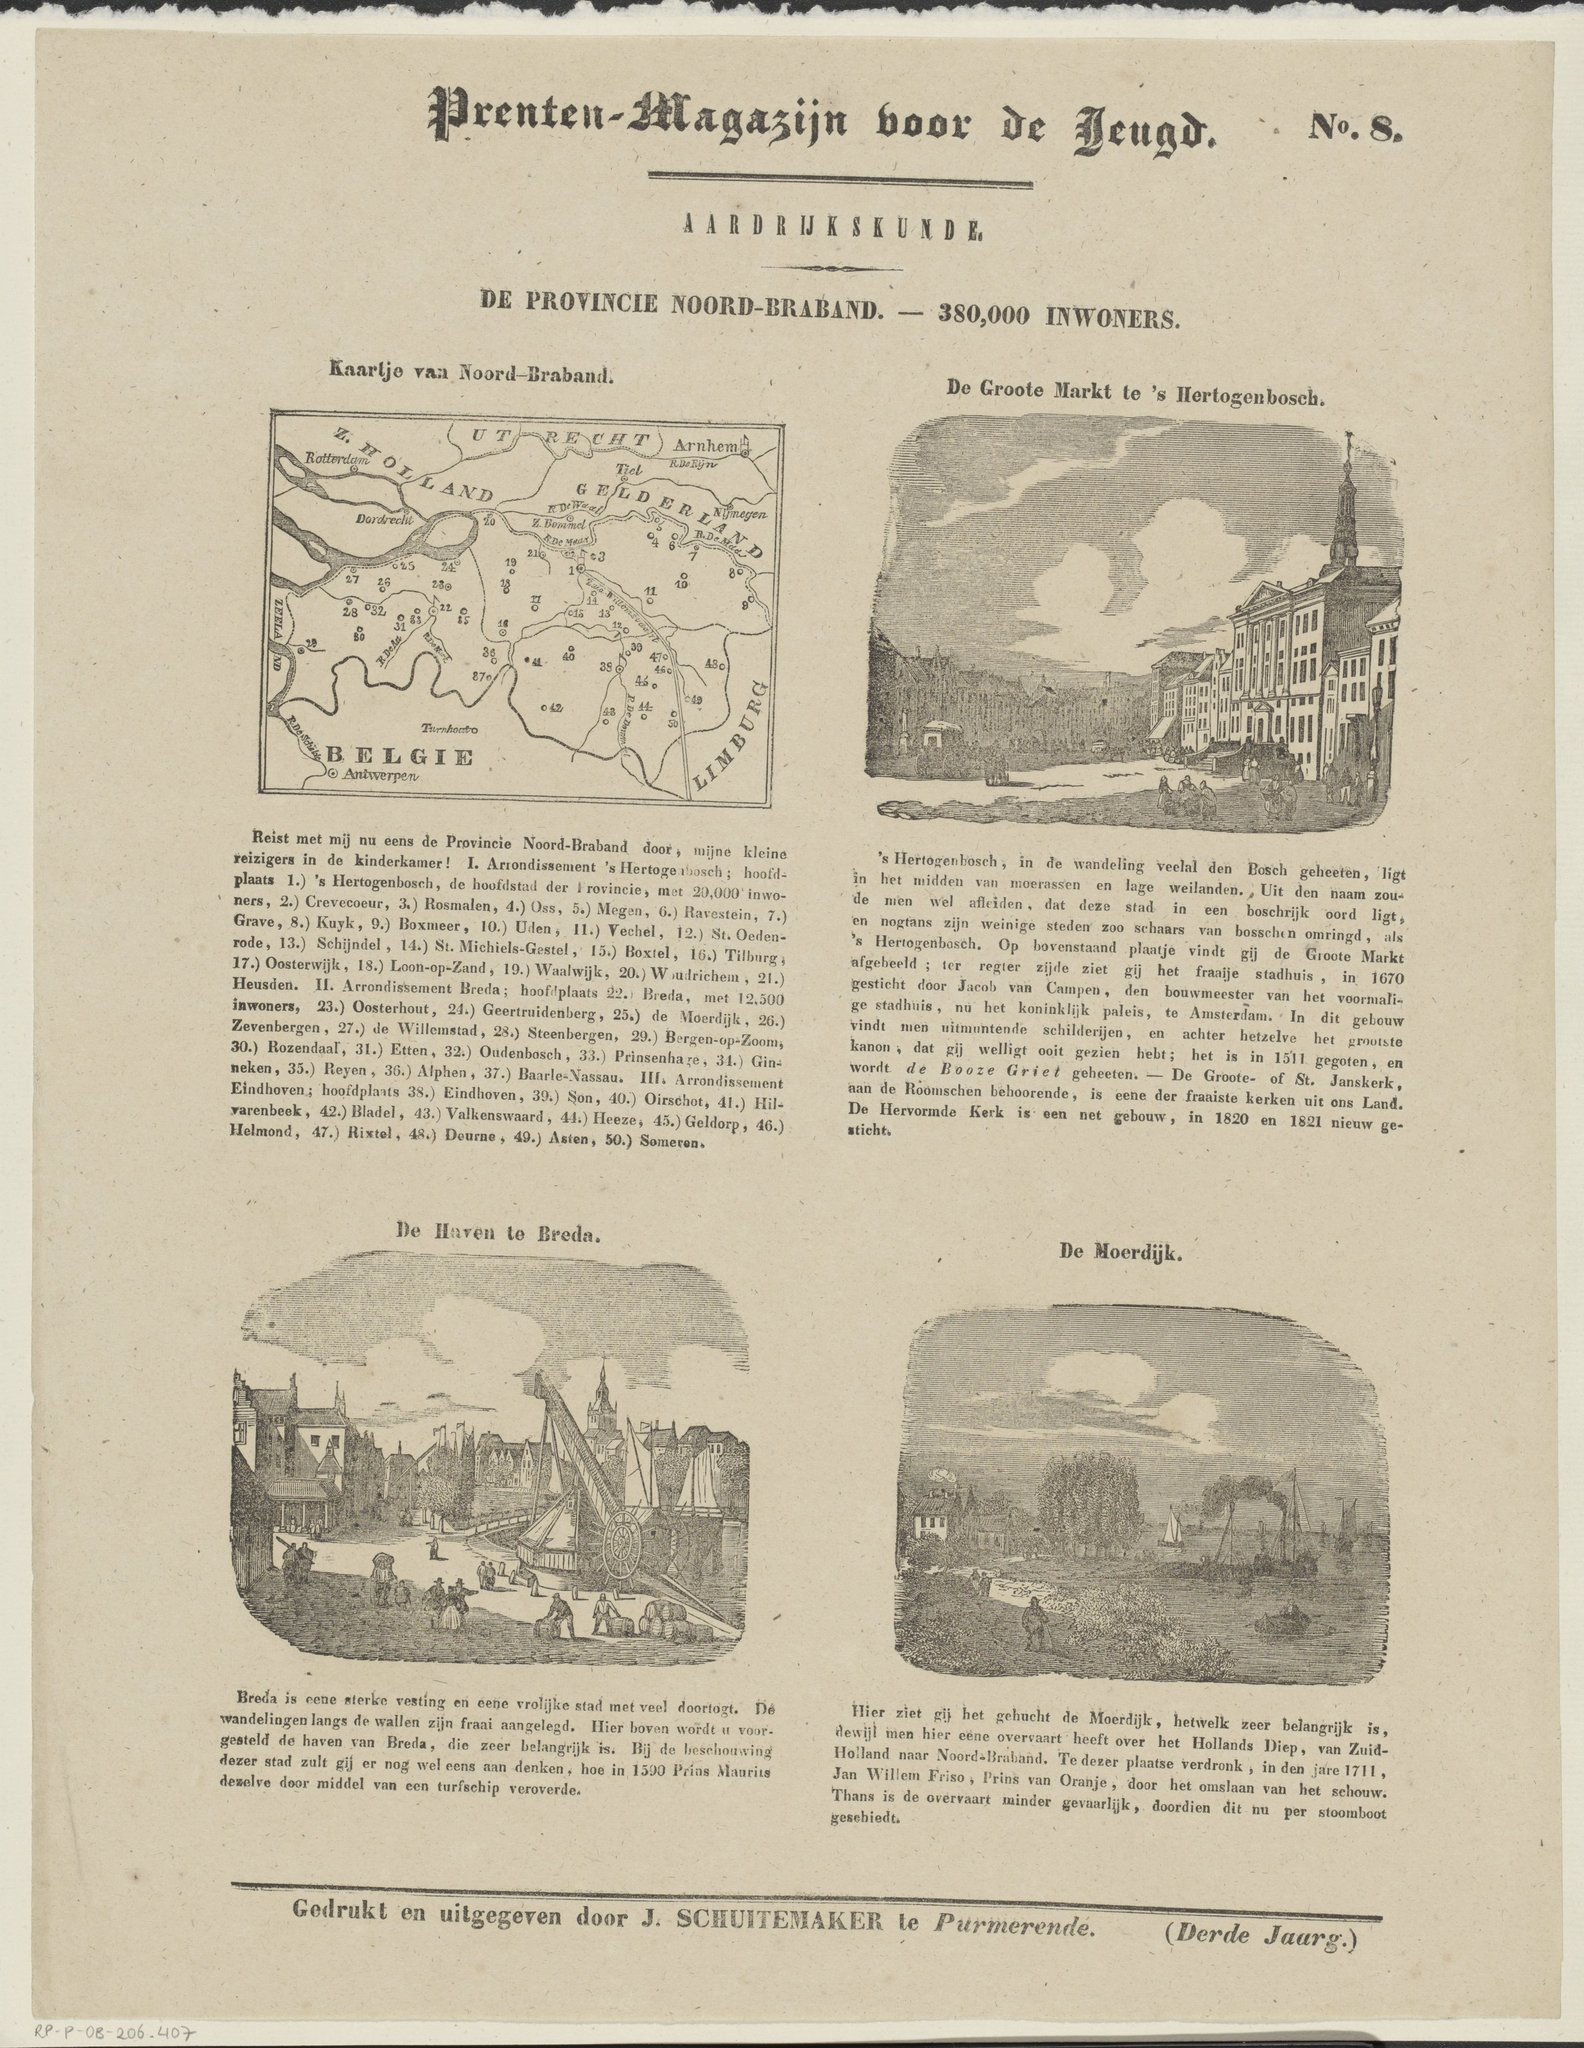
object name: popular print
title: Prenten-magazijn voor de jeugd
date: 1844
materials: paper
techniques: letterpress printing, engraving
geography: purmerend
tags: harbour, maps, atlases, den bosch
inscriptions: collector's mark: Lugt 2760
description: Blad met 4 voorstellingen over de provincie Noord-Brabant met een kaart en belangrijke plaatsen: de Grote Markt in Den Bosch, de haven van Breda en Moerdijk. Boven elke voorstelling een titel en onder elke voorstelling een onderschrift. Genummerd rechtsboven: No. 8.